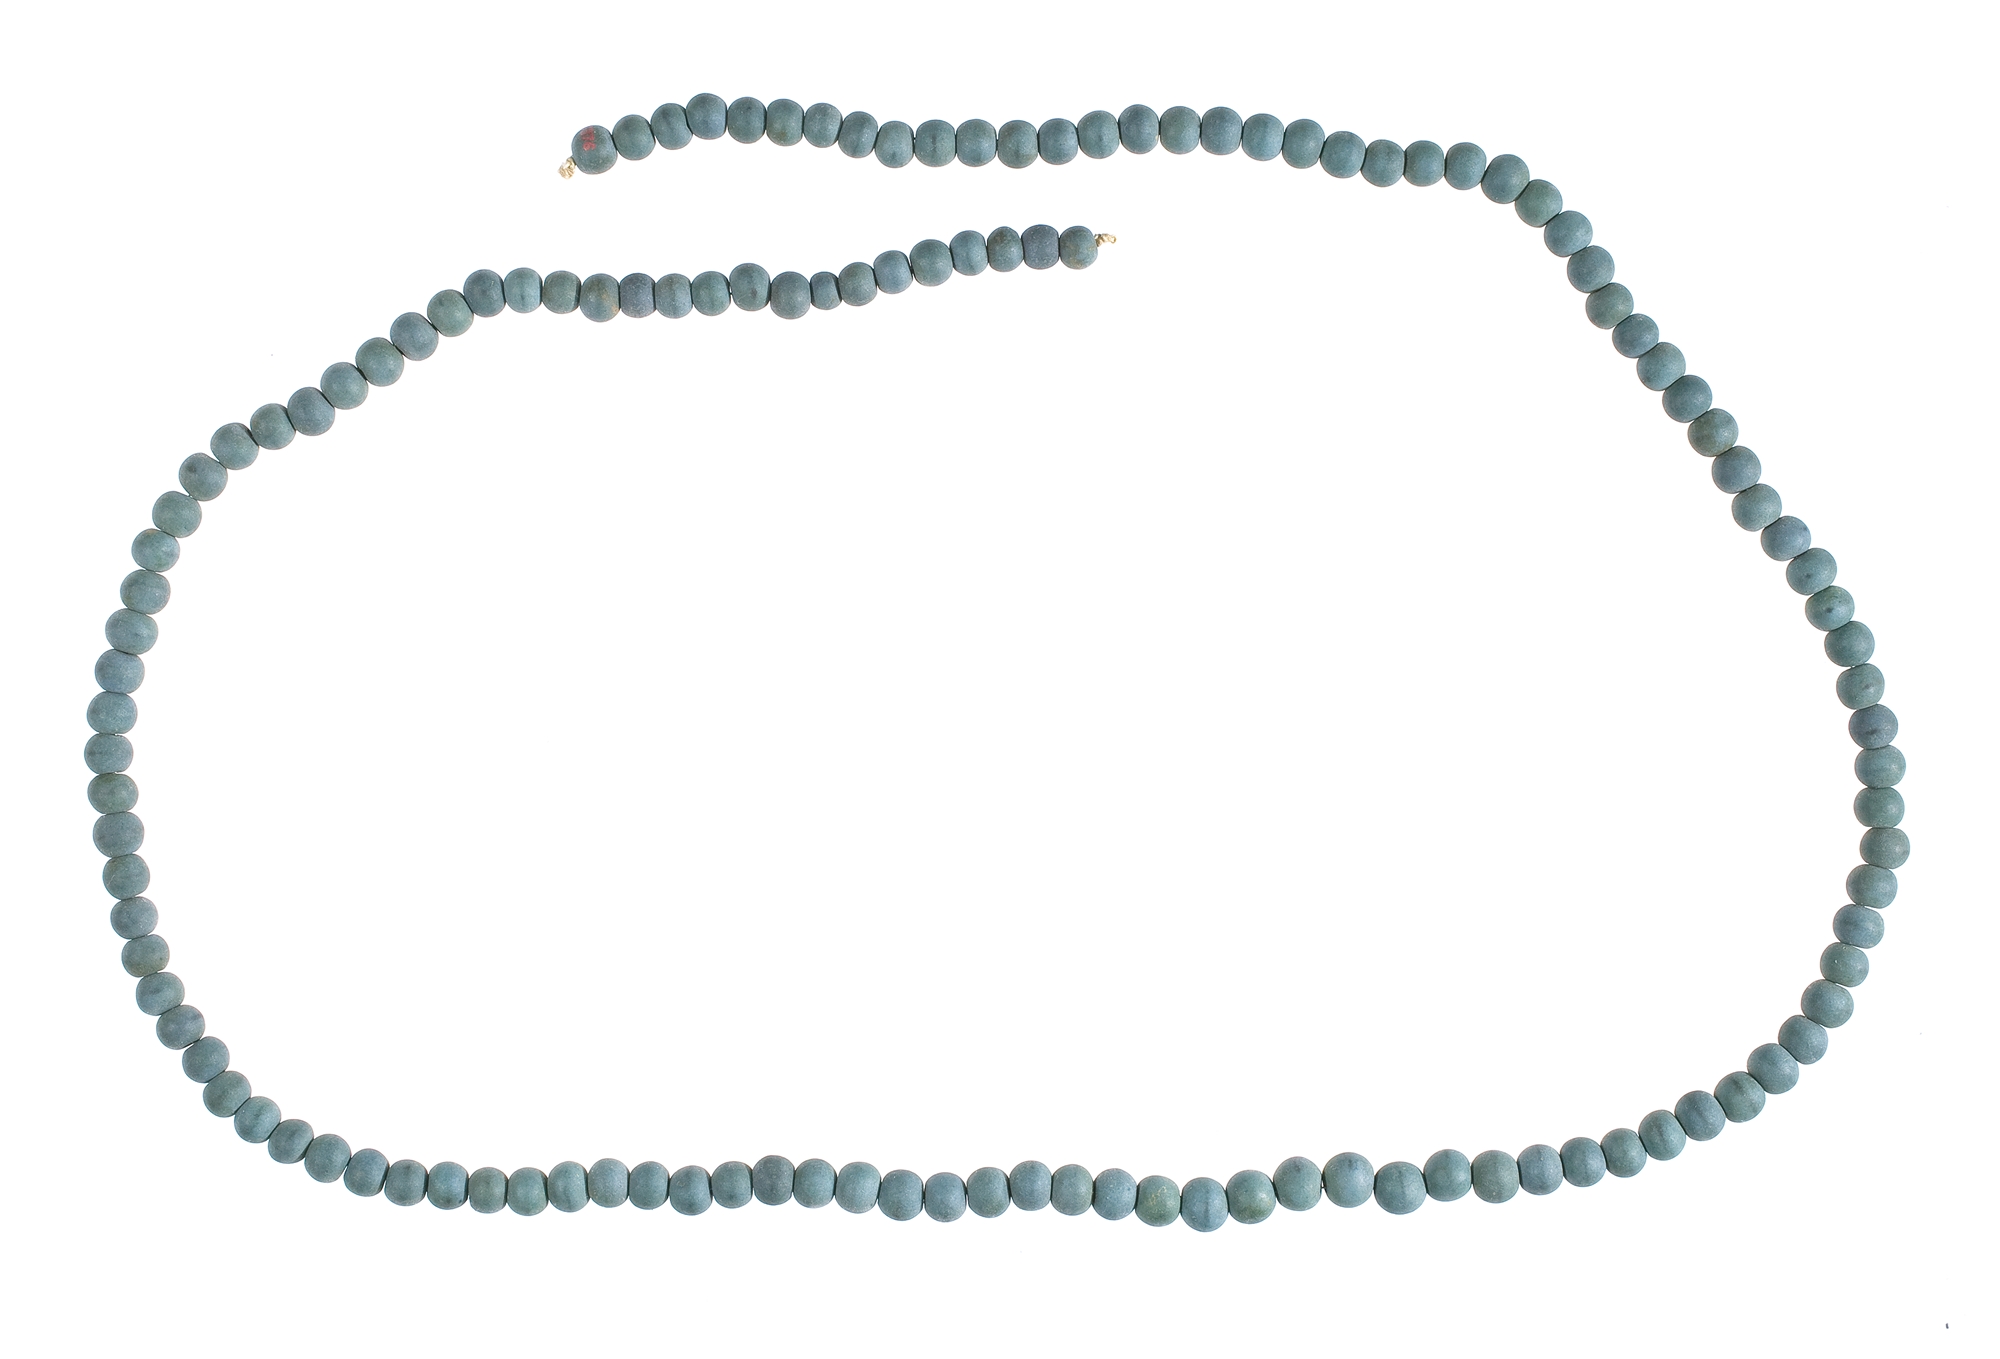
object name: necklace, bead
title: Necklace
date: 1550-1425 BCE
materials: paste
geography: egypt